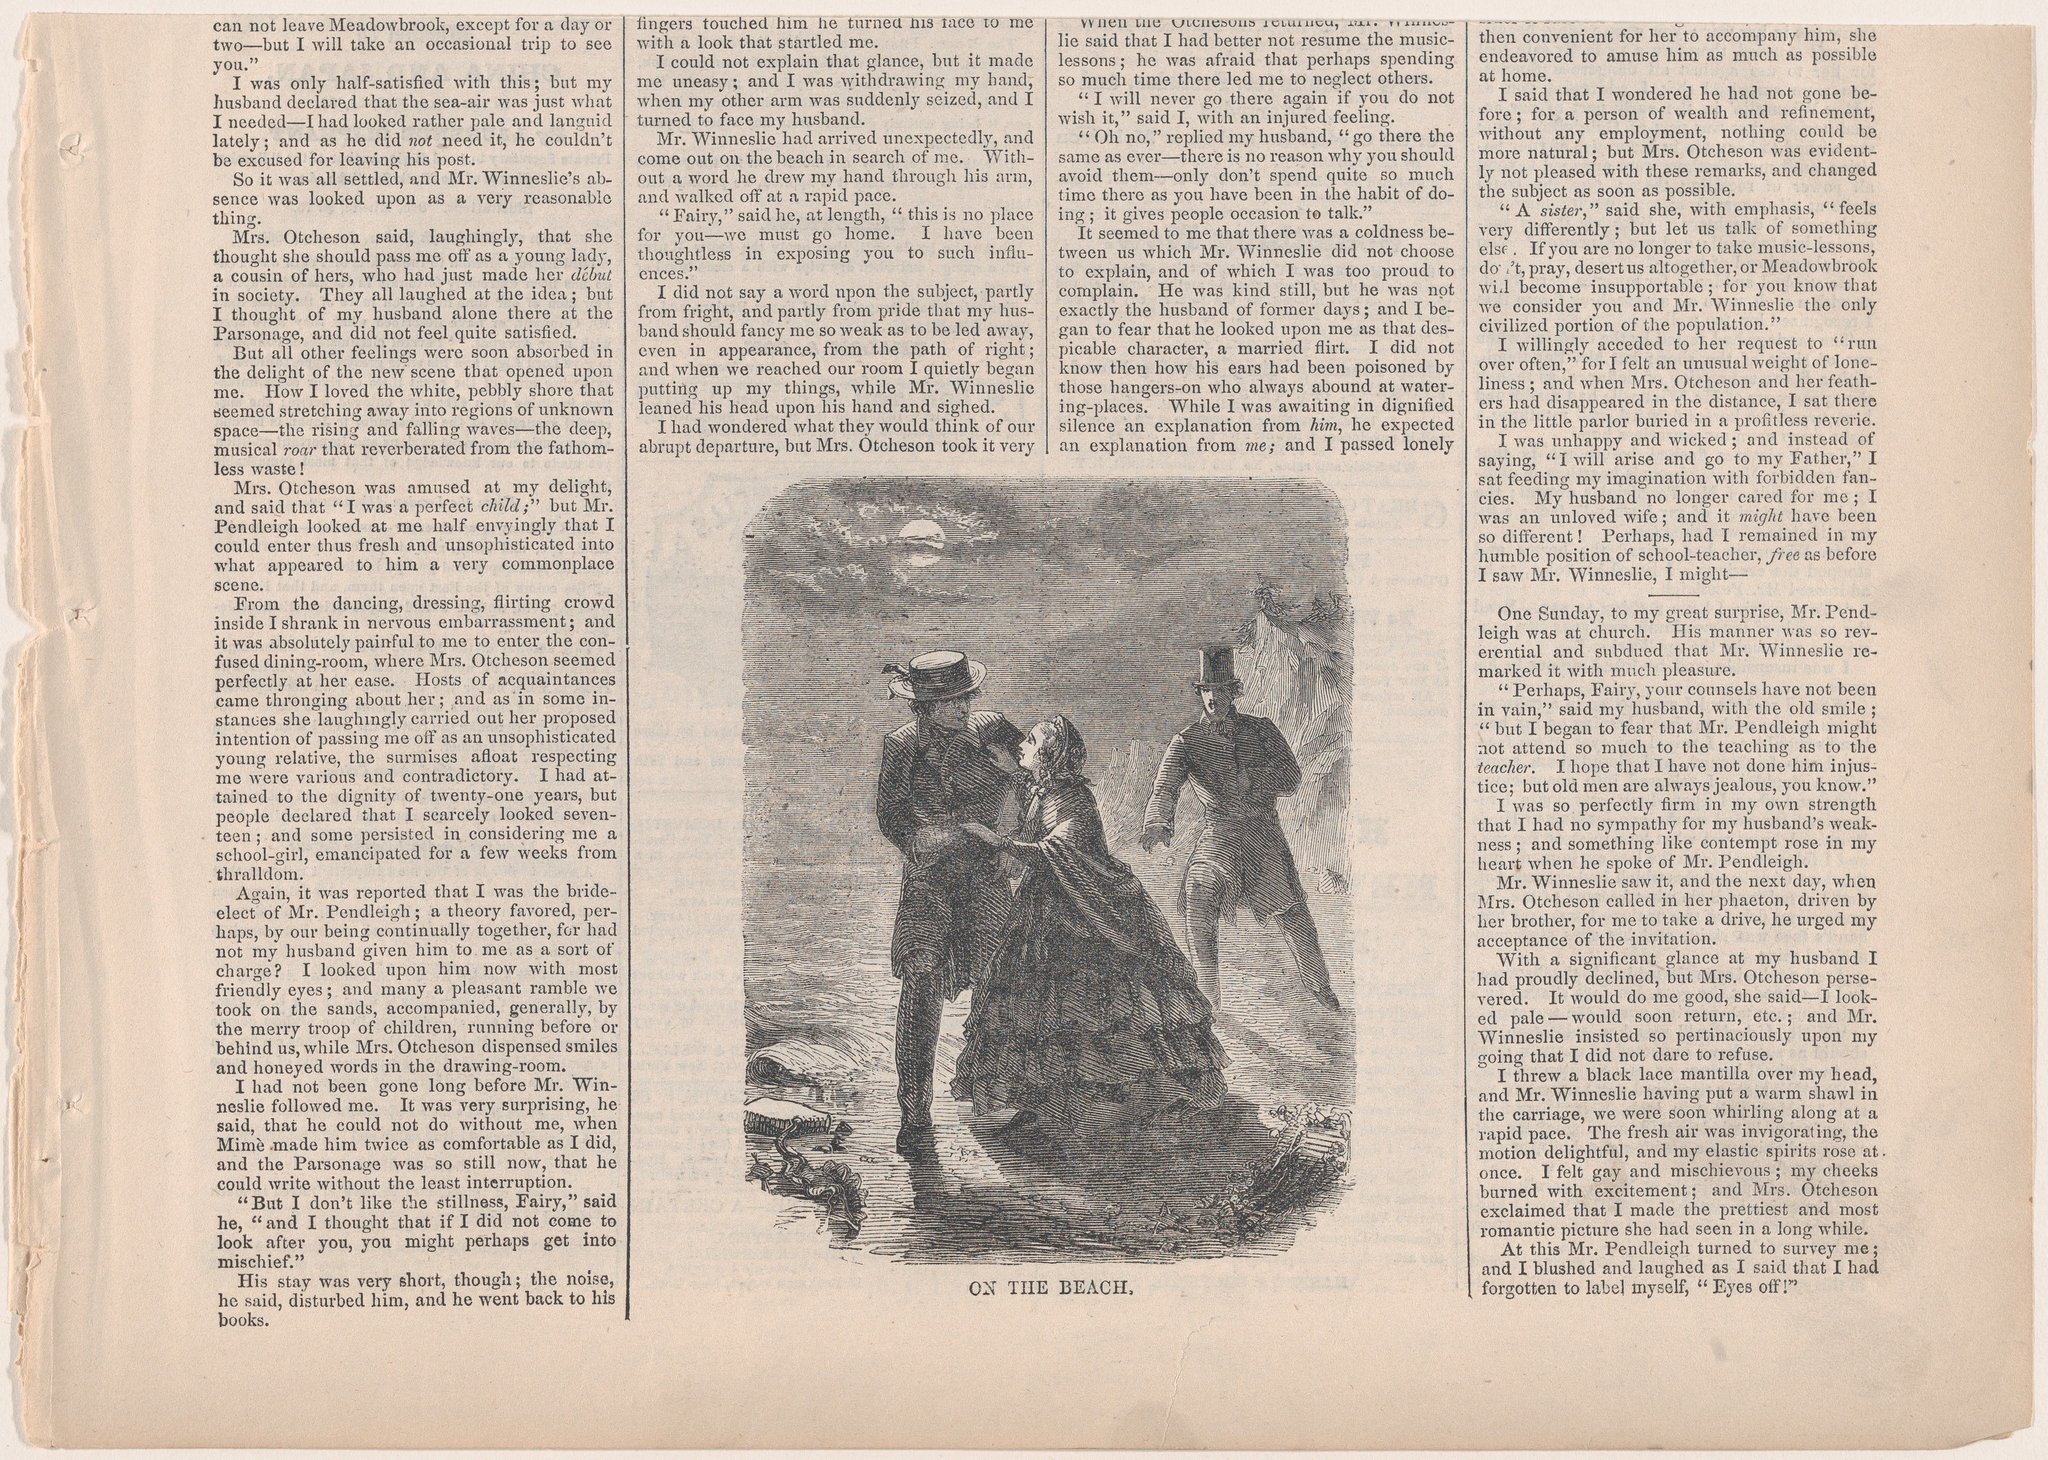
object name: print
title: On the Beach (from "The Mistress of the Parsonage," in "Harper's Weekly")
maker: winslow homer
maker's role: artist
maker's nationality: american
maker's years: 1836-1910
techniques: engraving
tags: men,women,beaches